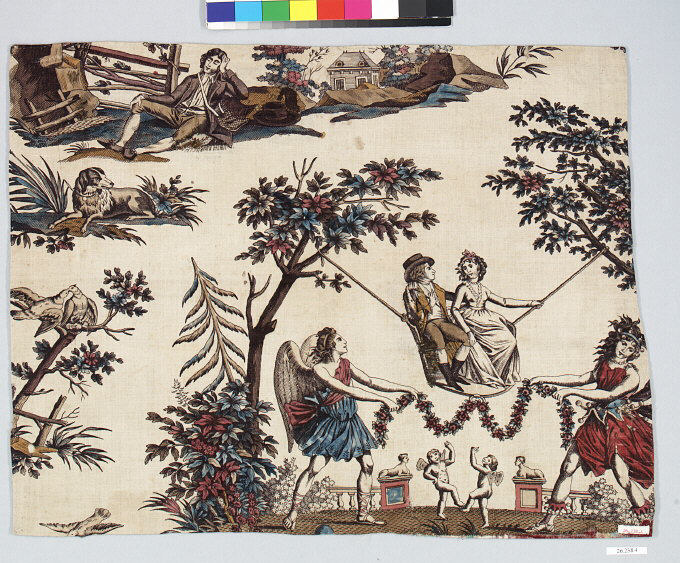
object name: piece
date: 1701-1800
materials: cotton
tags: birds,houses,men,women,dogs,flowers,leaves,trees,angels